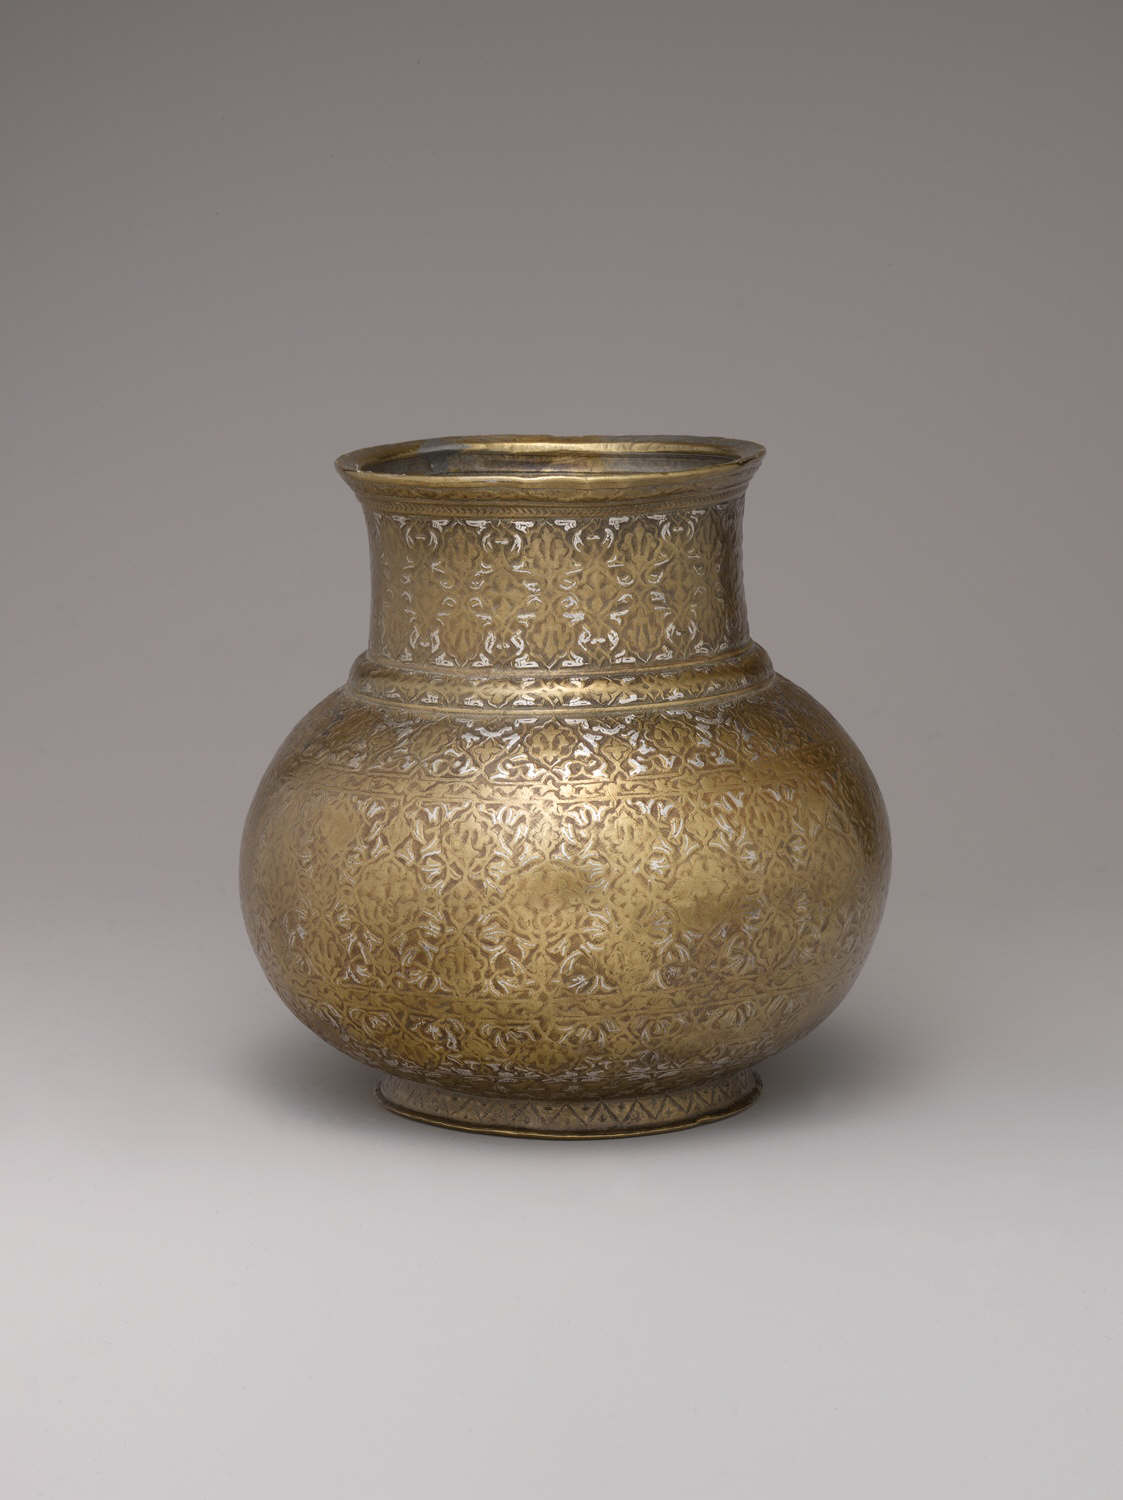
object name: ewer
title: Inlaid Ewer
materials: brass, silver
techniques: casting, engraving, inlay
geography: iran